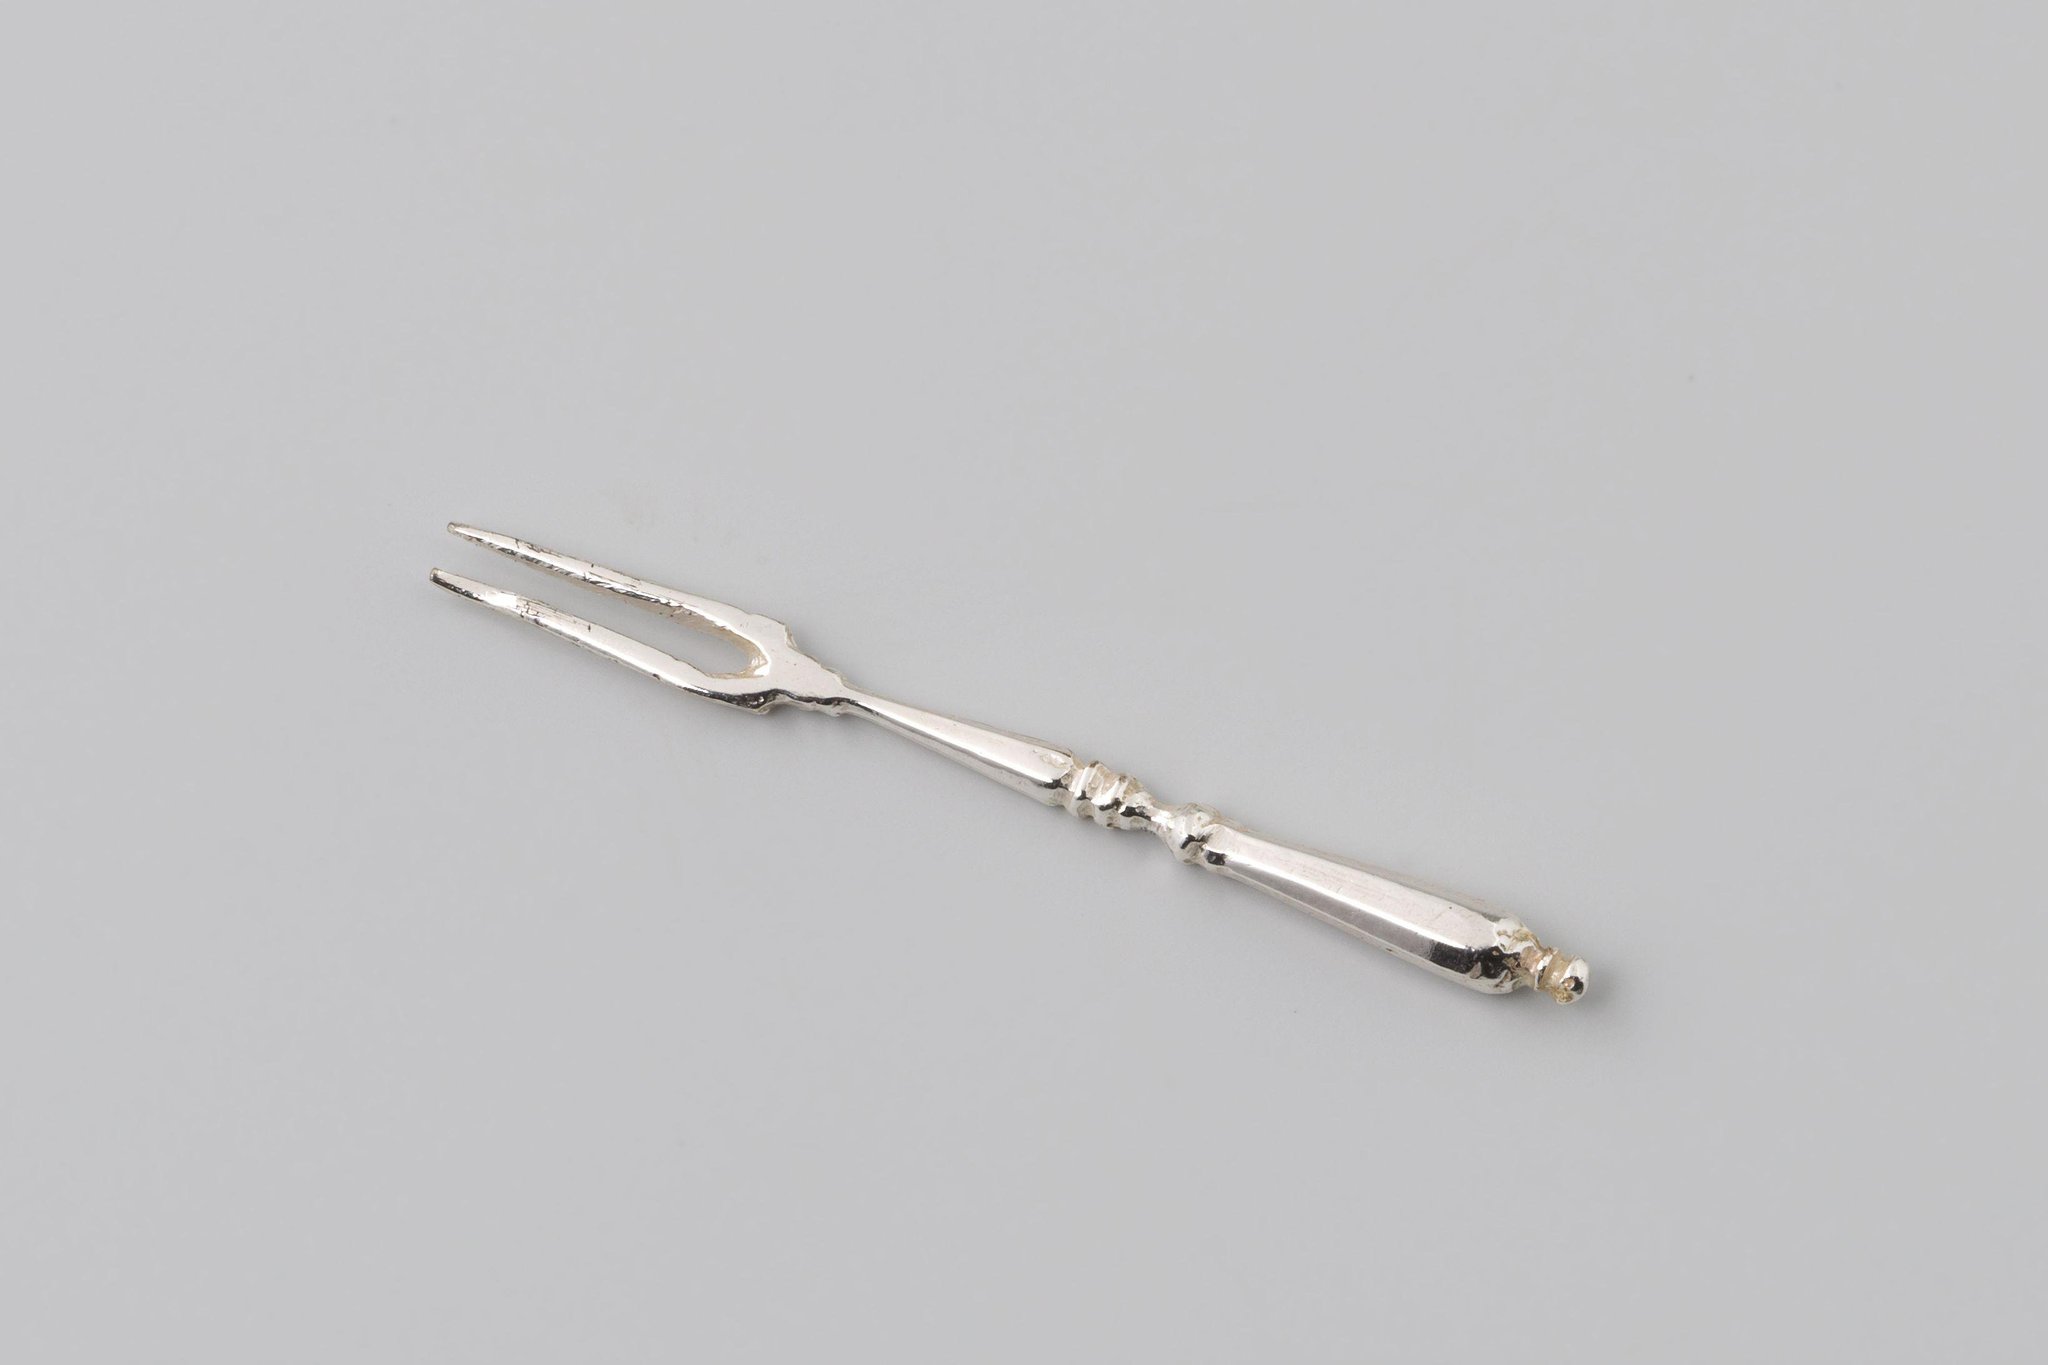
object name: miniature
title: Vleesvork van zilver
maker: Anonymous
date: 1675-1700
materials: silver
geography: amsterdam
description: Vleesvork van zilver, met twee tanden aan een zeshoekige steel met knopversiering.